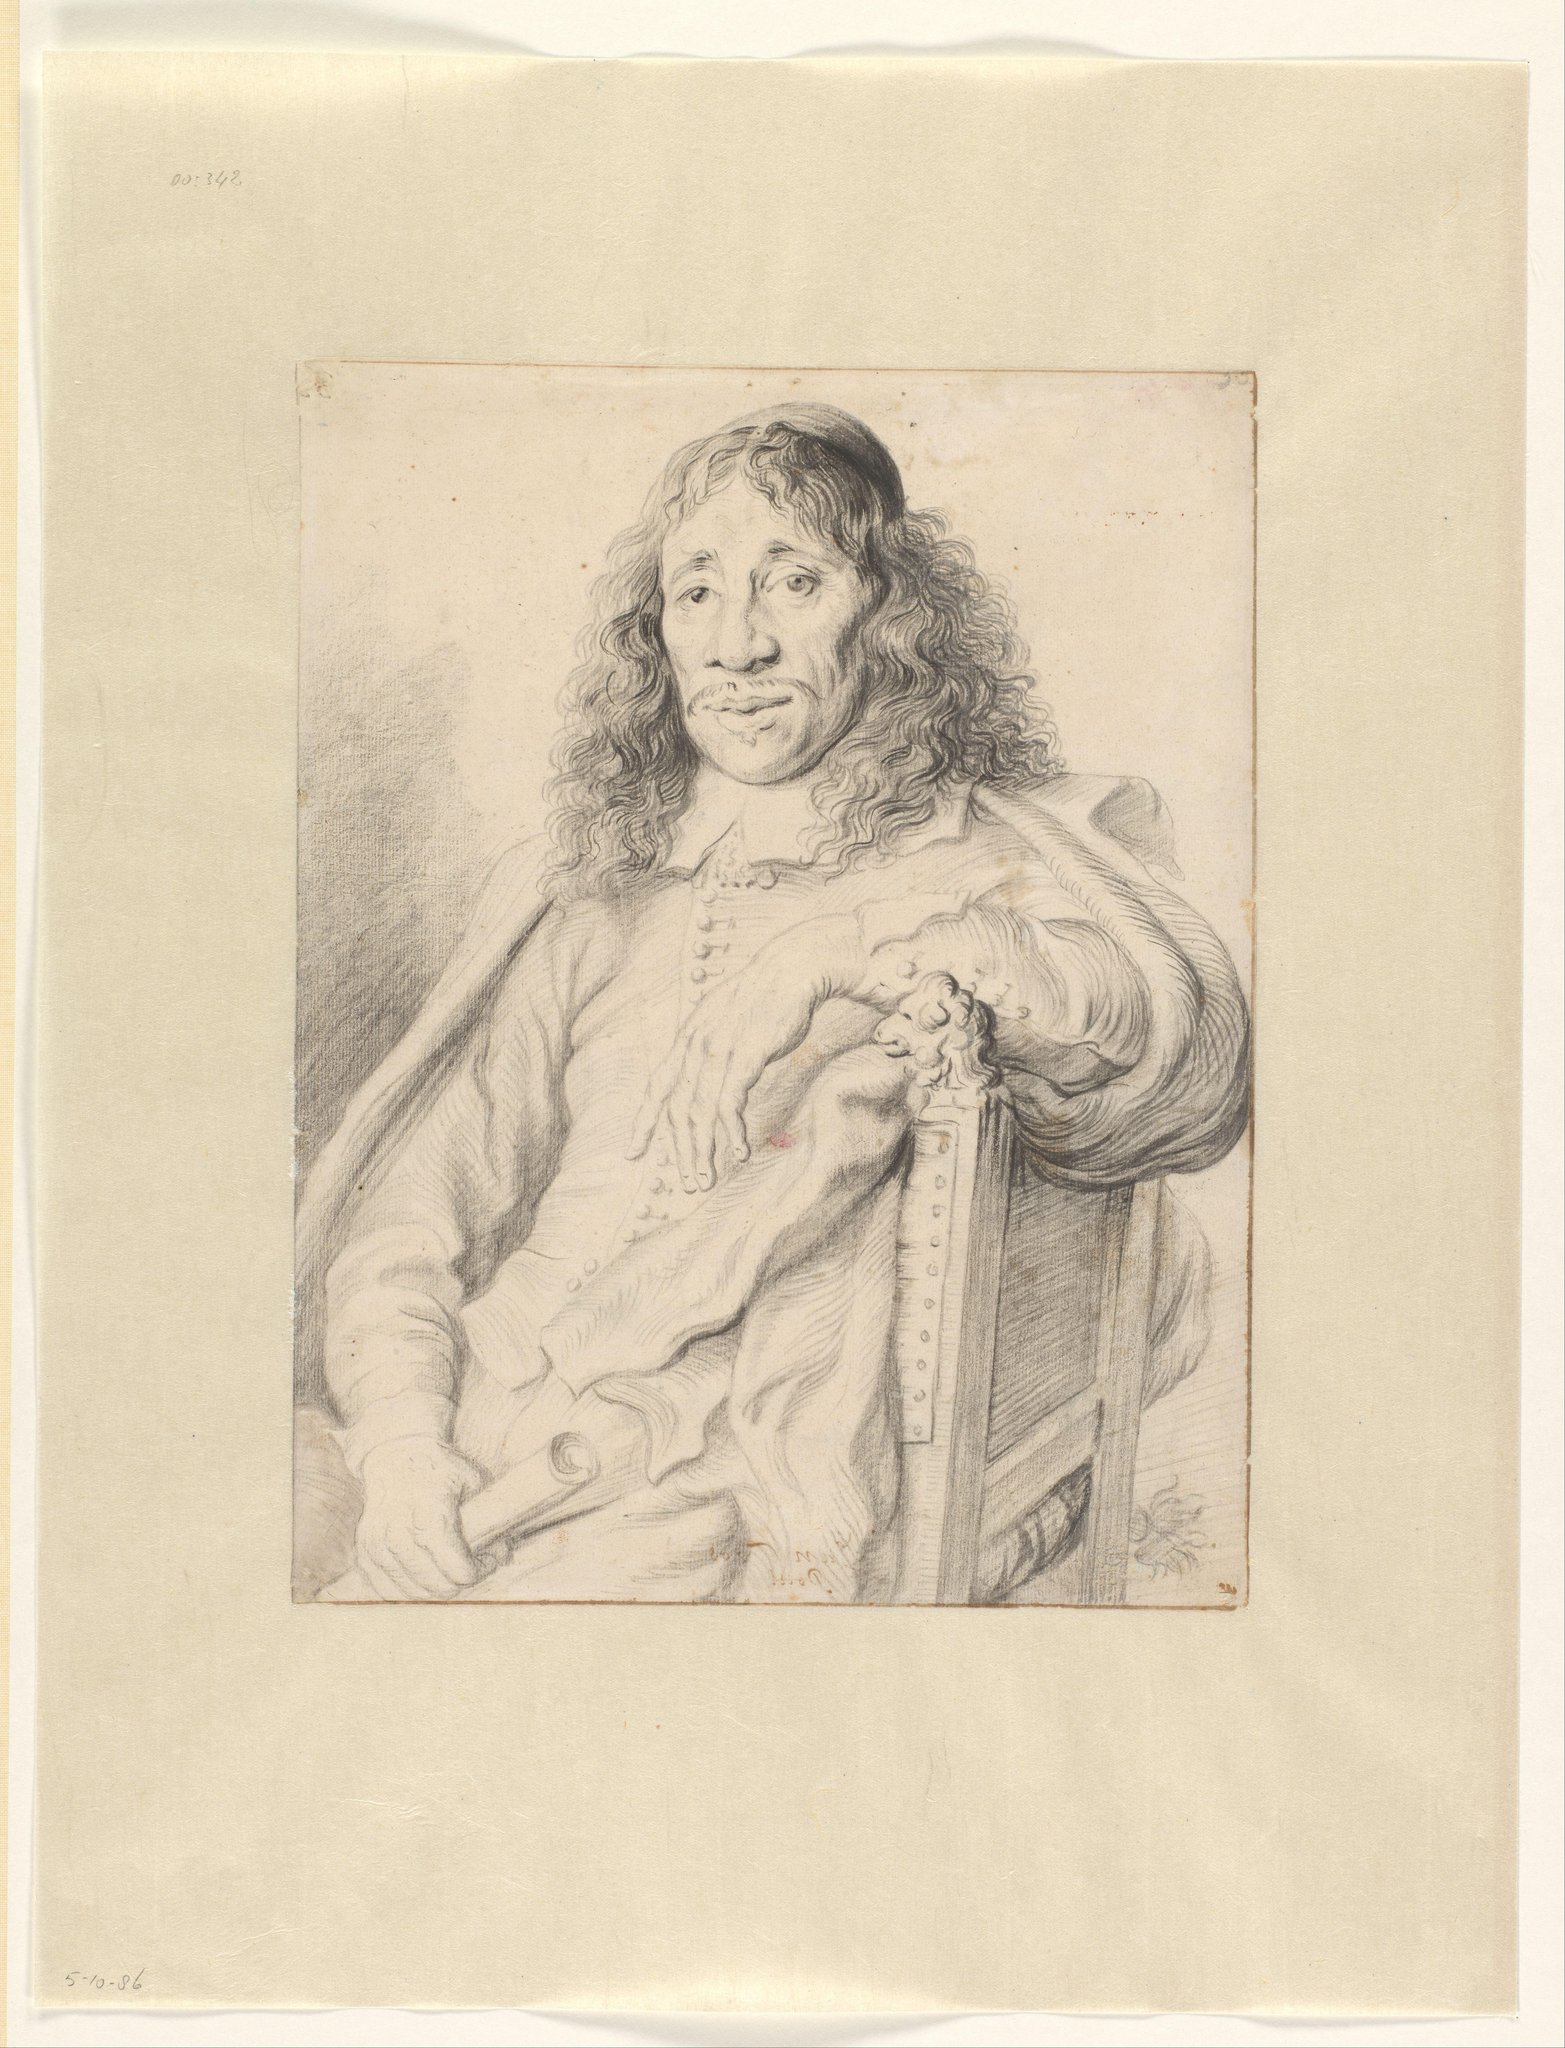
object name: drawing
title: Portret van Jan Vos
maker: Anonymous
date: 1660-1700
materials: chalk, paper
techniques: brush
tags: amsterdam, jan vos, historical persons, portrait of a writer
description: Portret van Jan Vos, dichter te Amsterdam.